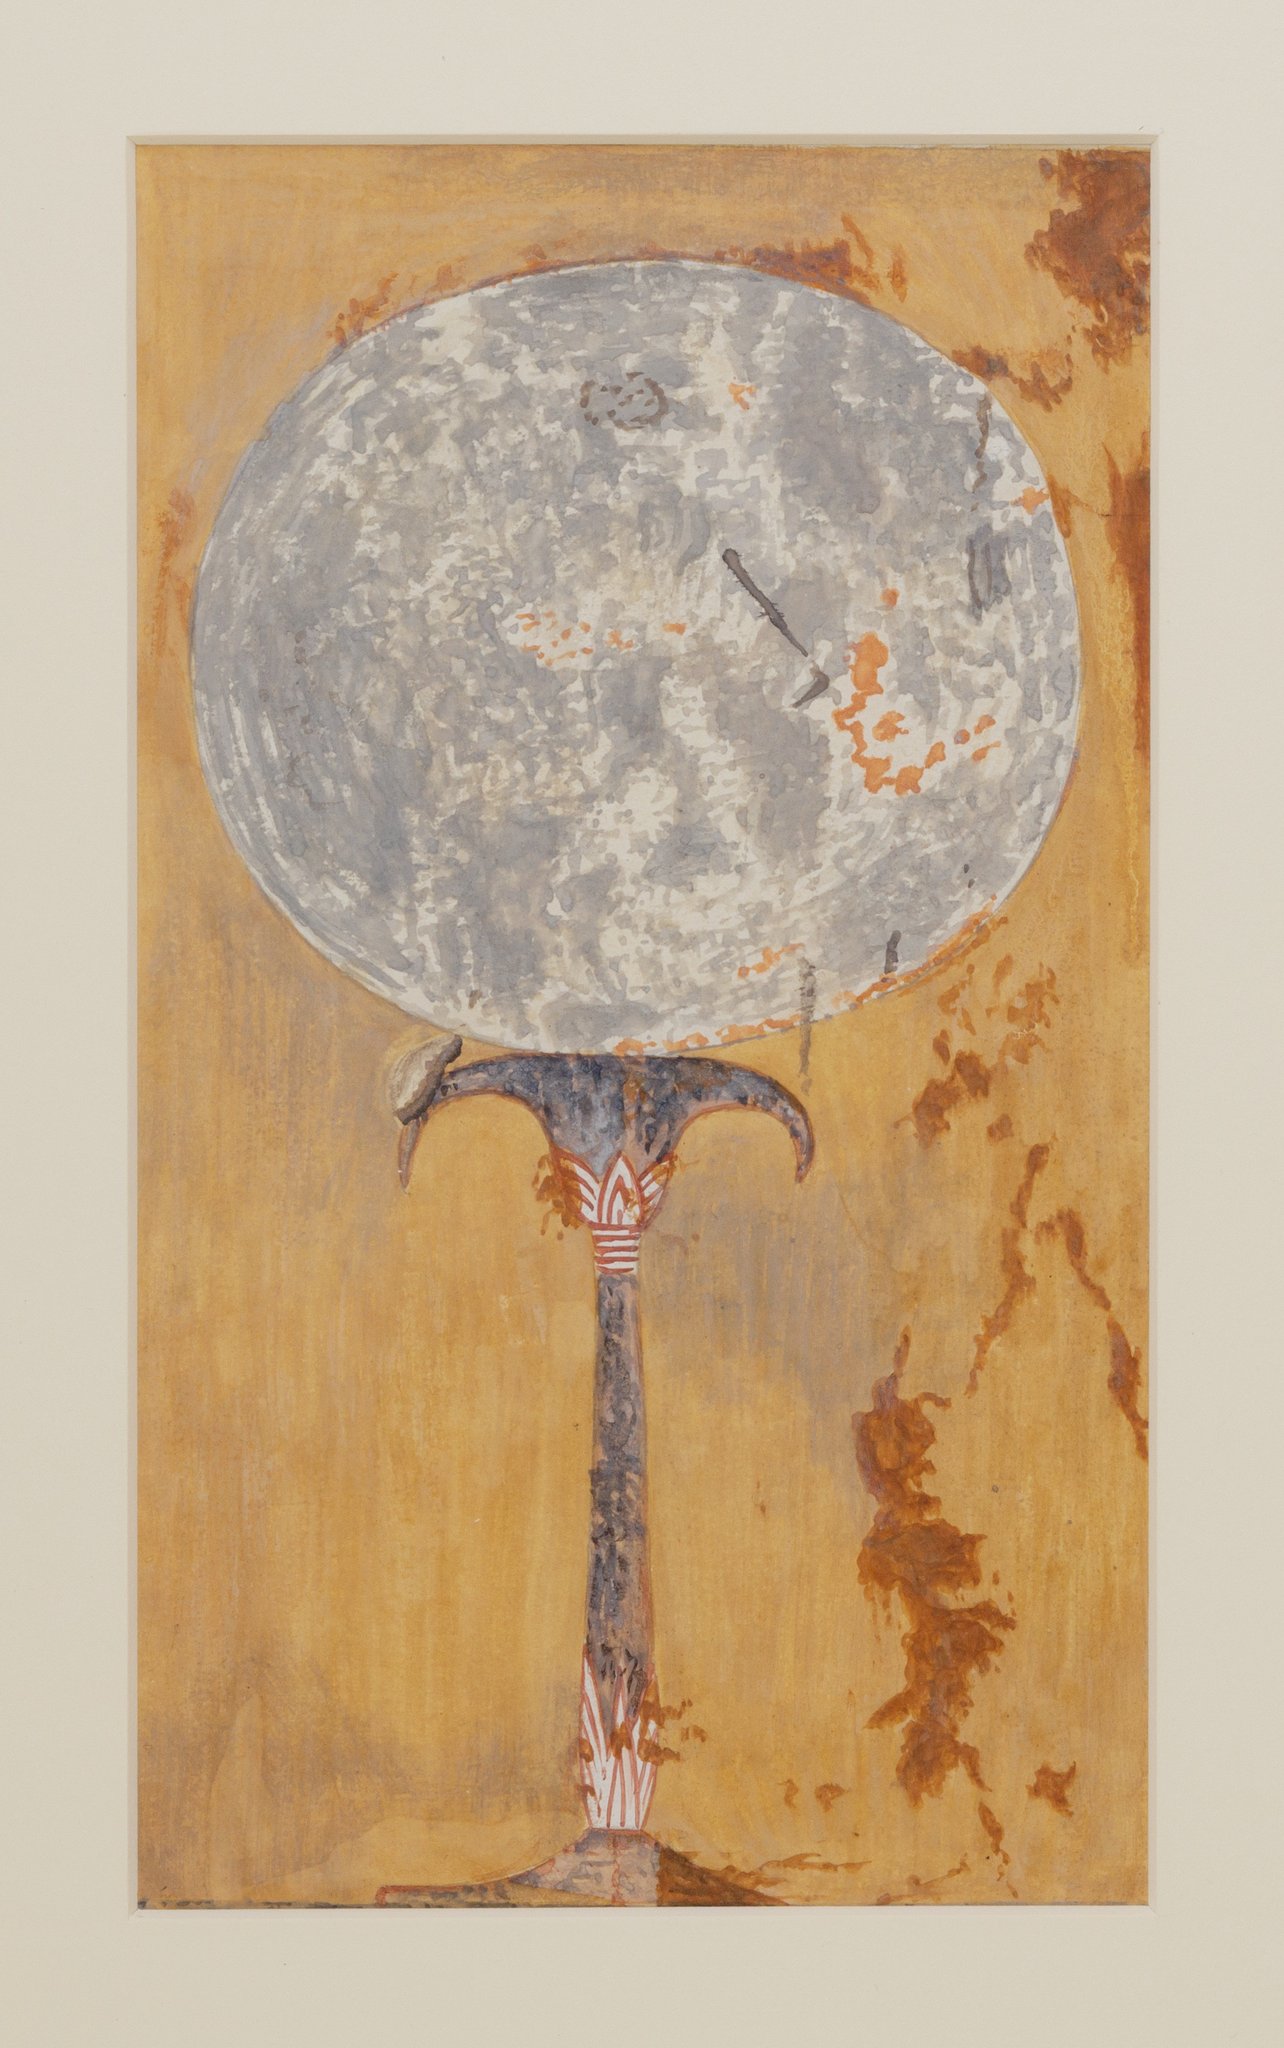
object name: facsimile, qenamun tt 93, mirror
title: New Year Gift: Mirror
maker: norman de garis davies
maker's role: artist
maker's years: 1865-1941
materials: paper, paint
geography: egypt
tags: drink-and-be-merry